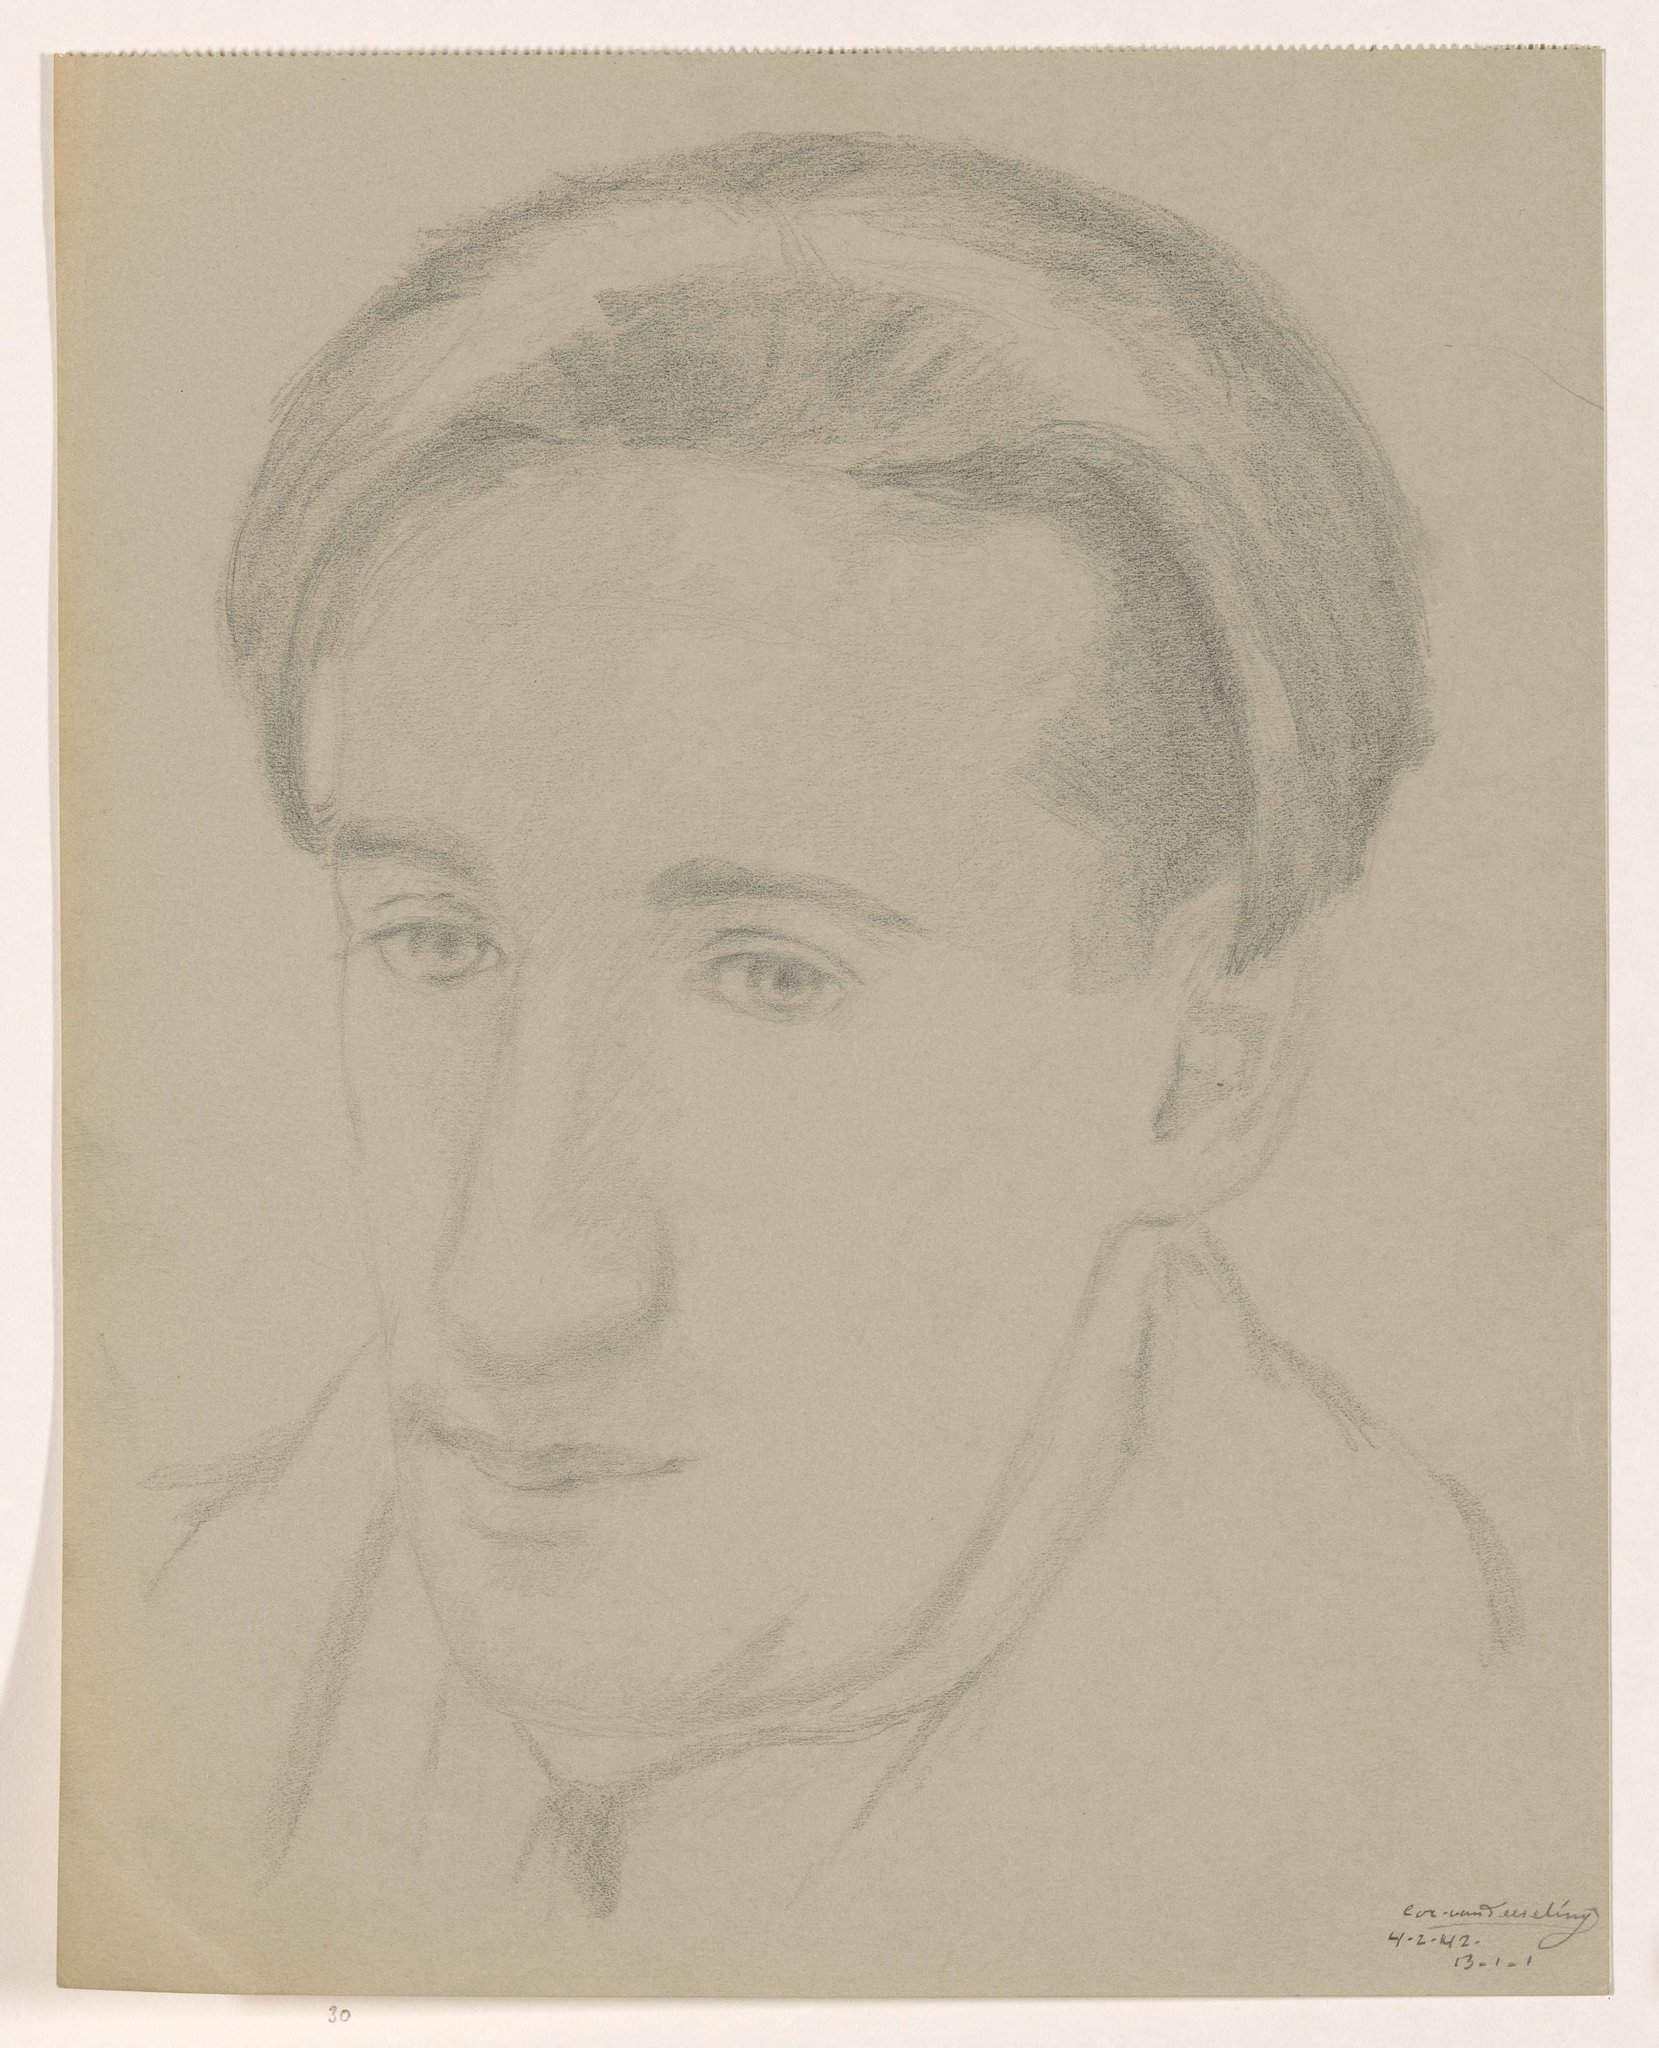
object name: drawing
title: Zelfportret: B-1-1, 4 februari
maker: cor van teeseling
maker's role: draughtsman, sculptor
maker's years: 1915-1942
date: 1942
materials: paper, pencil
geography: weteringschans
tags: amsterdam, draughtsman, sculptor, cor van teeseling, historical persons, prisoner in cell or locked place, portrait, self-portrait of draughtsman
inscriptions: signature and date: ‘4-2-1942 / Cor van Teeseling / B-1-1’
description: Zelfportret van Cor van Teeseling: in de gevangenis aan de Weteringschans, cel B-1-1, 4 februari. Getekend zelfportret van Cor van Teeseling driekwart met zijn hoofd naar links gewend.